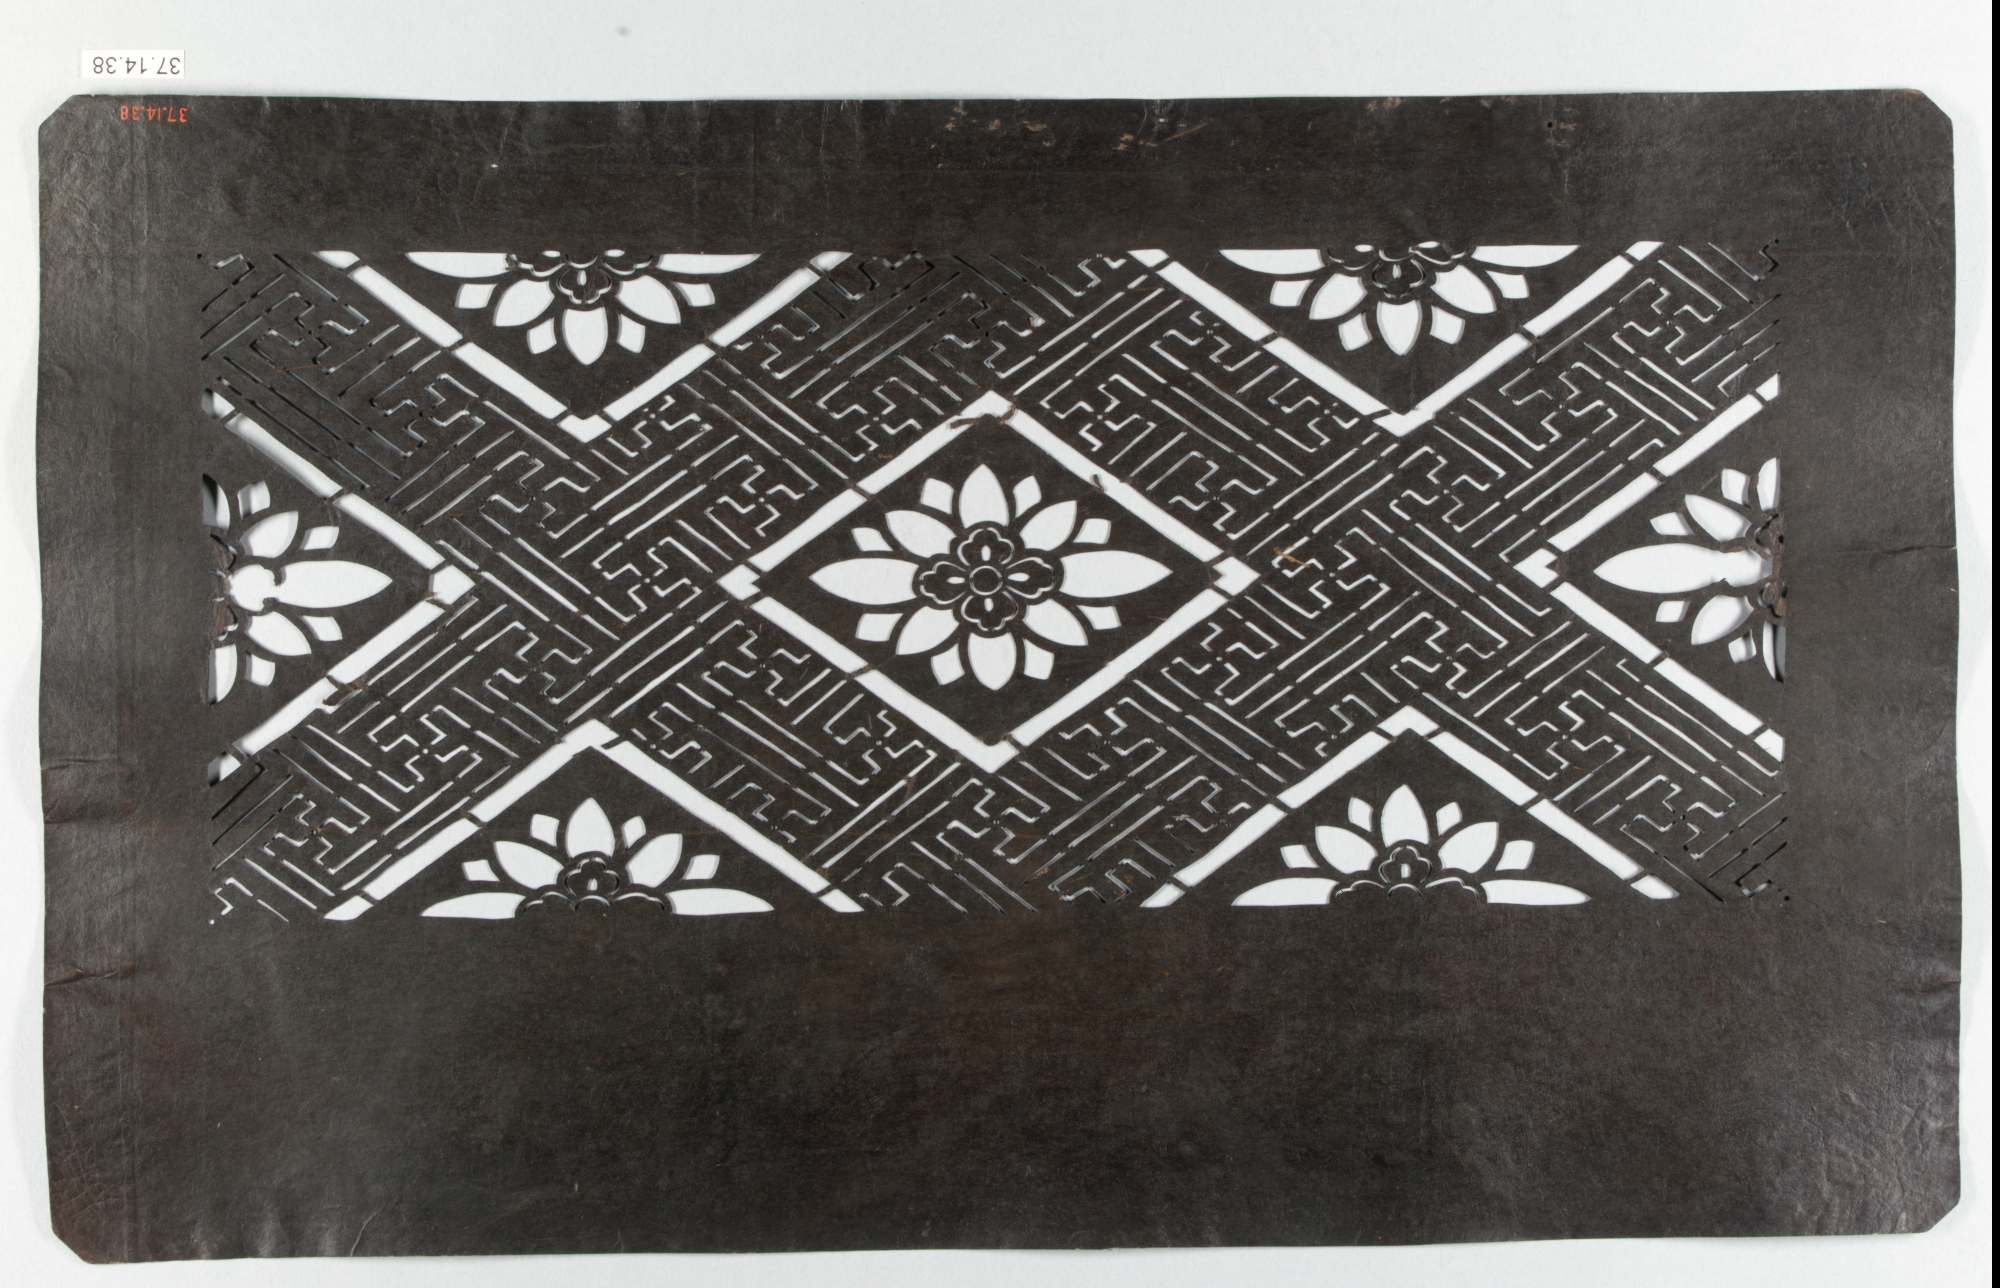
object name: stencil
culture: japanese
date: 1801-1833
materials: paper